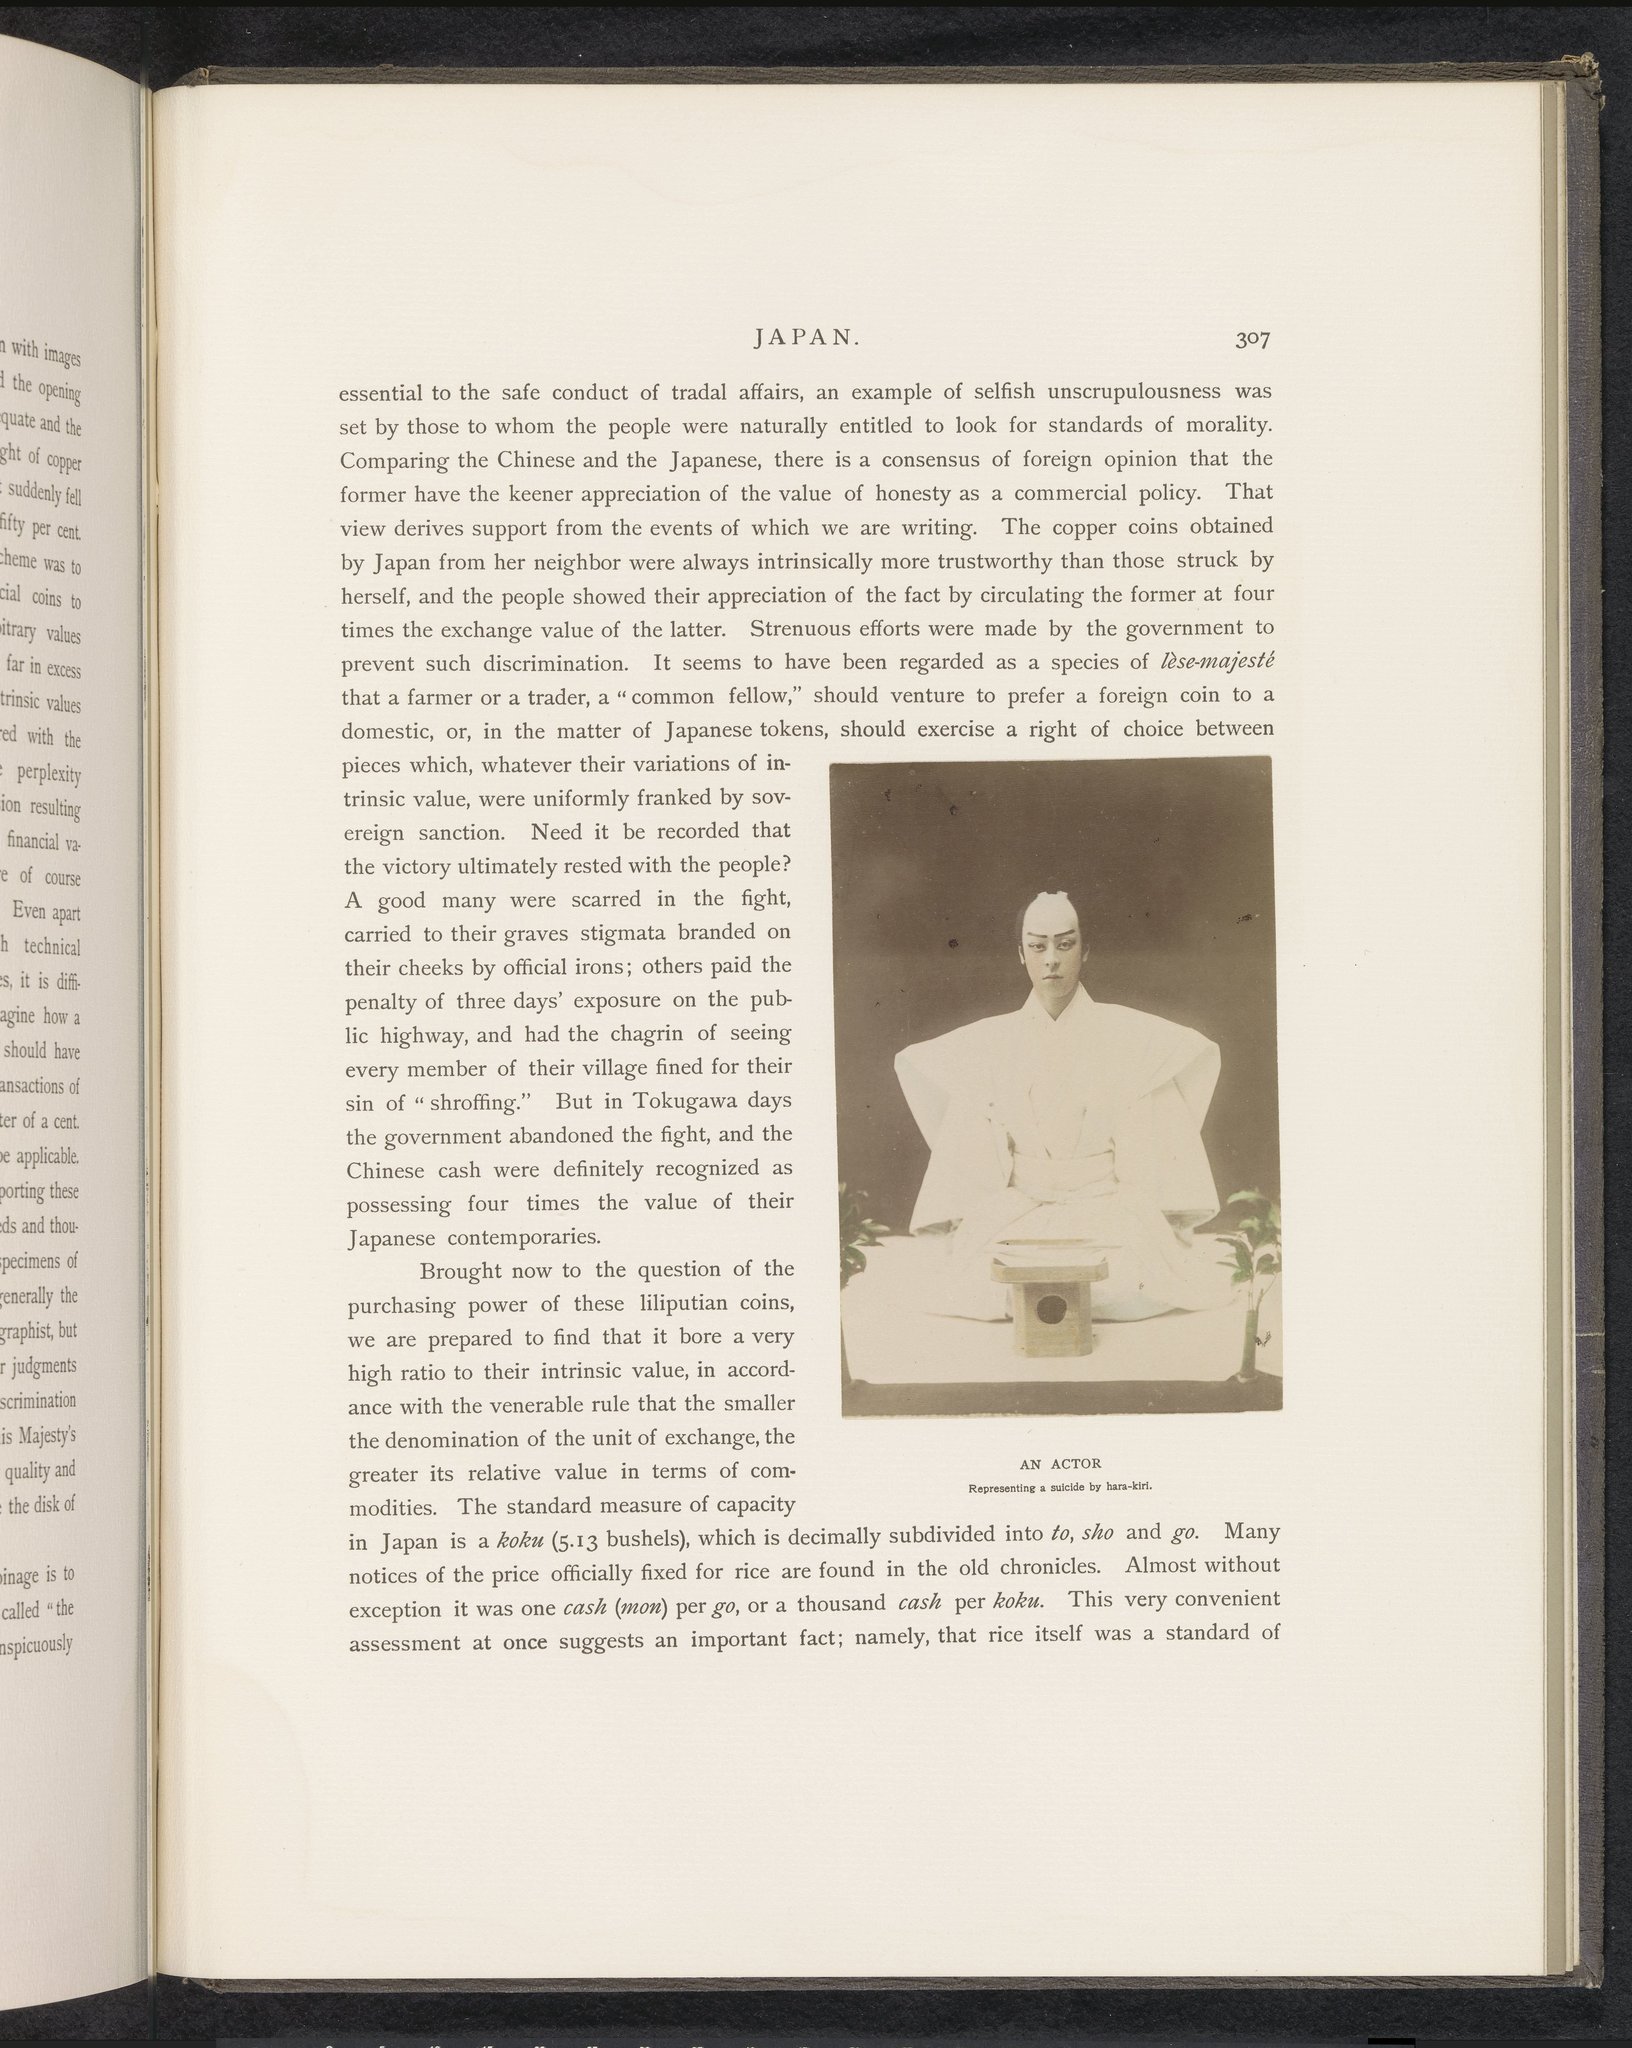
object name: page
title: An actor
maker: Anonymous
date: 1887-1897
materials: photographic support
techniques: albumen print, hand coloring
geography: japan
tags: portrait of actor, actress, seeking death, suicide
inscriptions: inscription: ‘Representing a suicide by hara-kiri.’